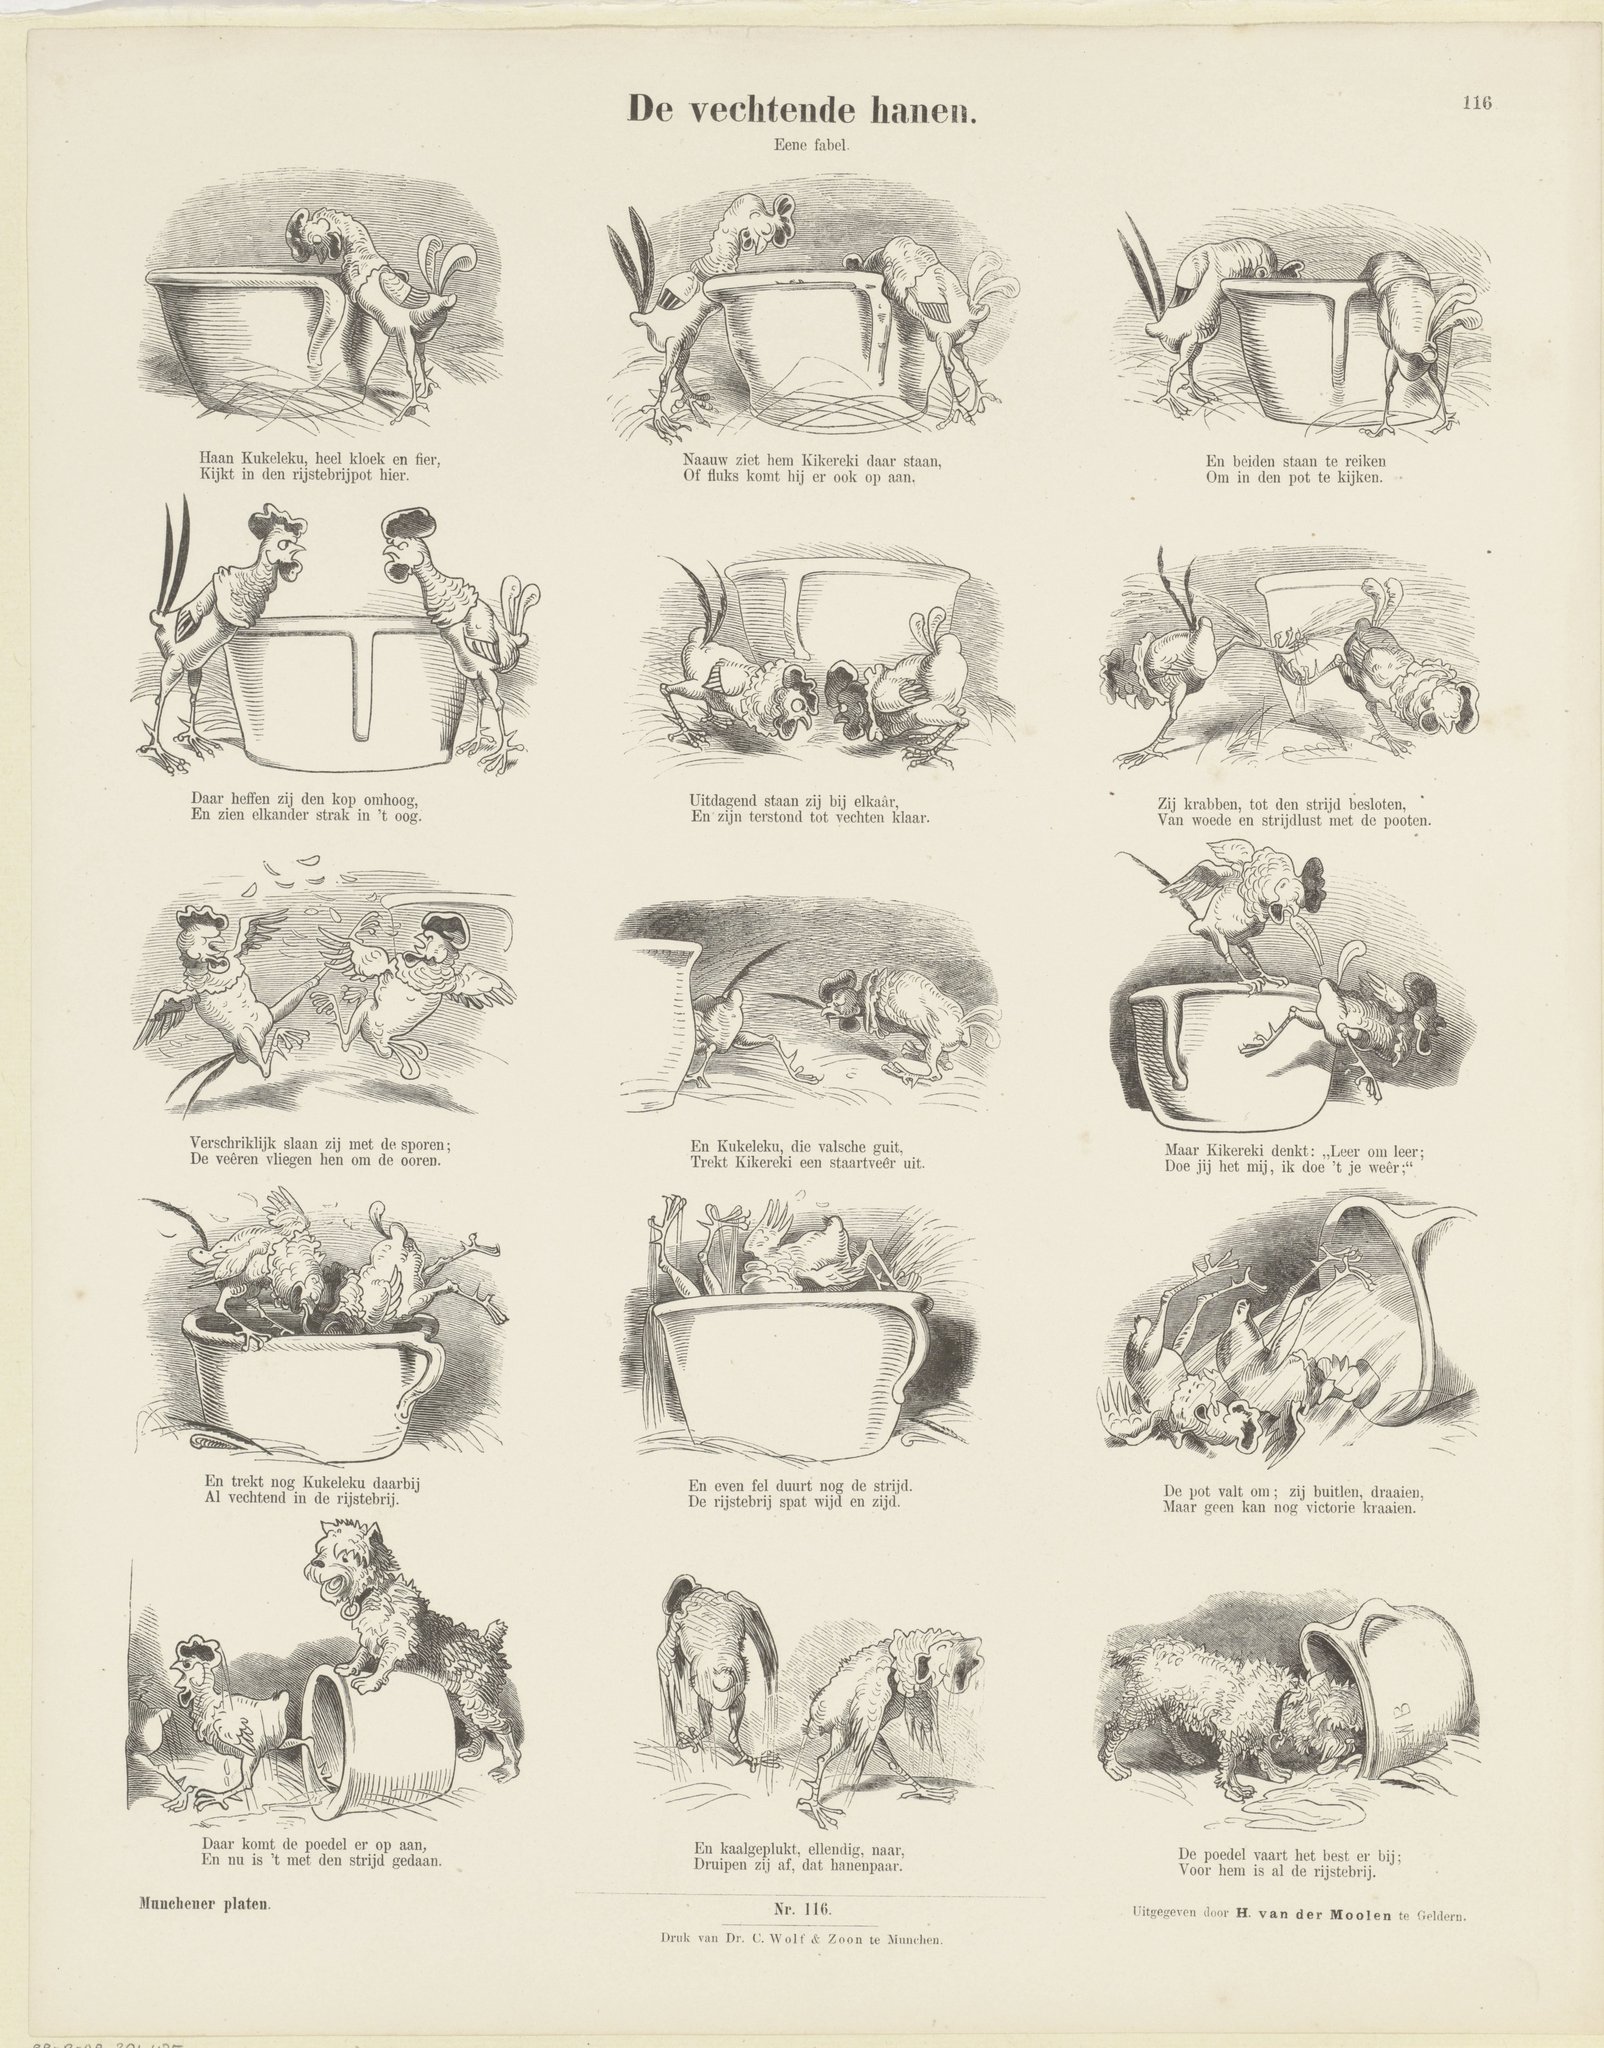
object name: popular print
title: De vechtende hanen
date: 1843-1920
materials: paper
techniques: letterpress printing, engraving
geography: munich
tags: fowl (cock, hen, chicken, etc.), cock-fighting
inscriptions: collector's mark: Lugt 2760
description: Nederlandse editie van een prent uit de reeks "Munchener platen" uitgegeven door K. Braun & Fr. Schneider te München met het adres van wederverkoper Hermann van der Moolen.